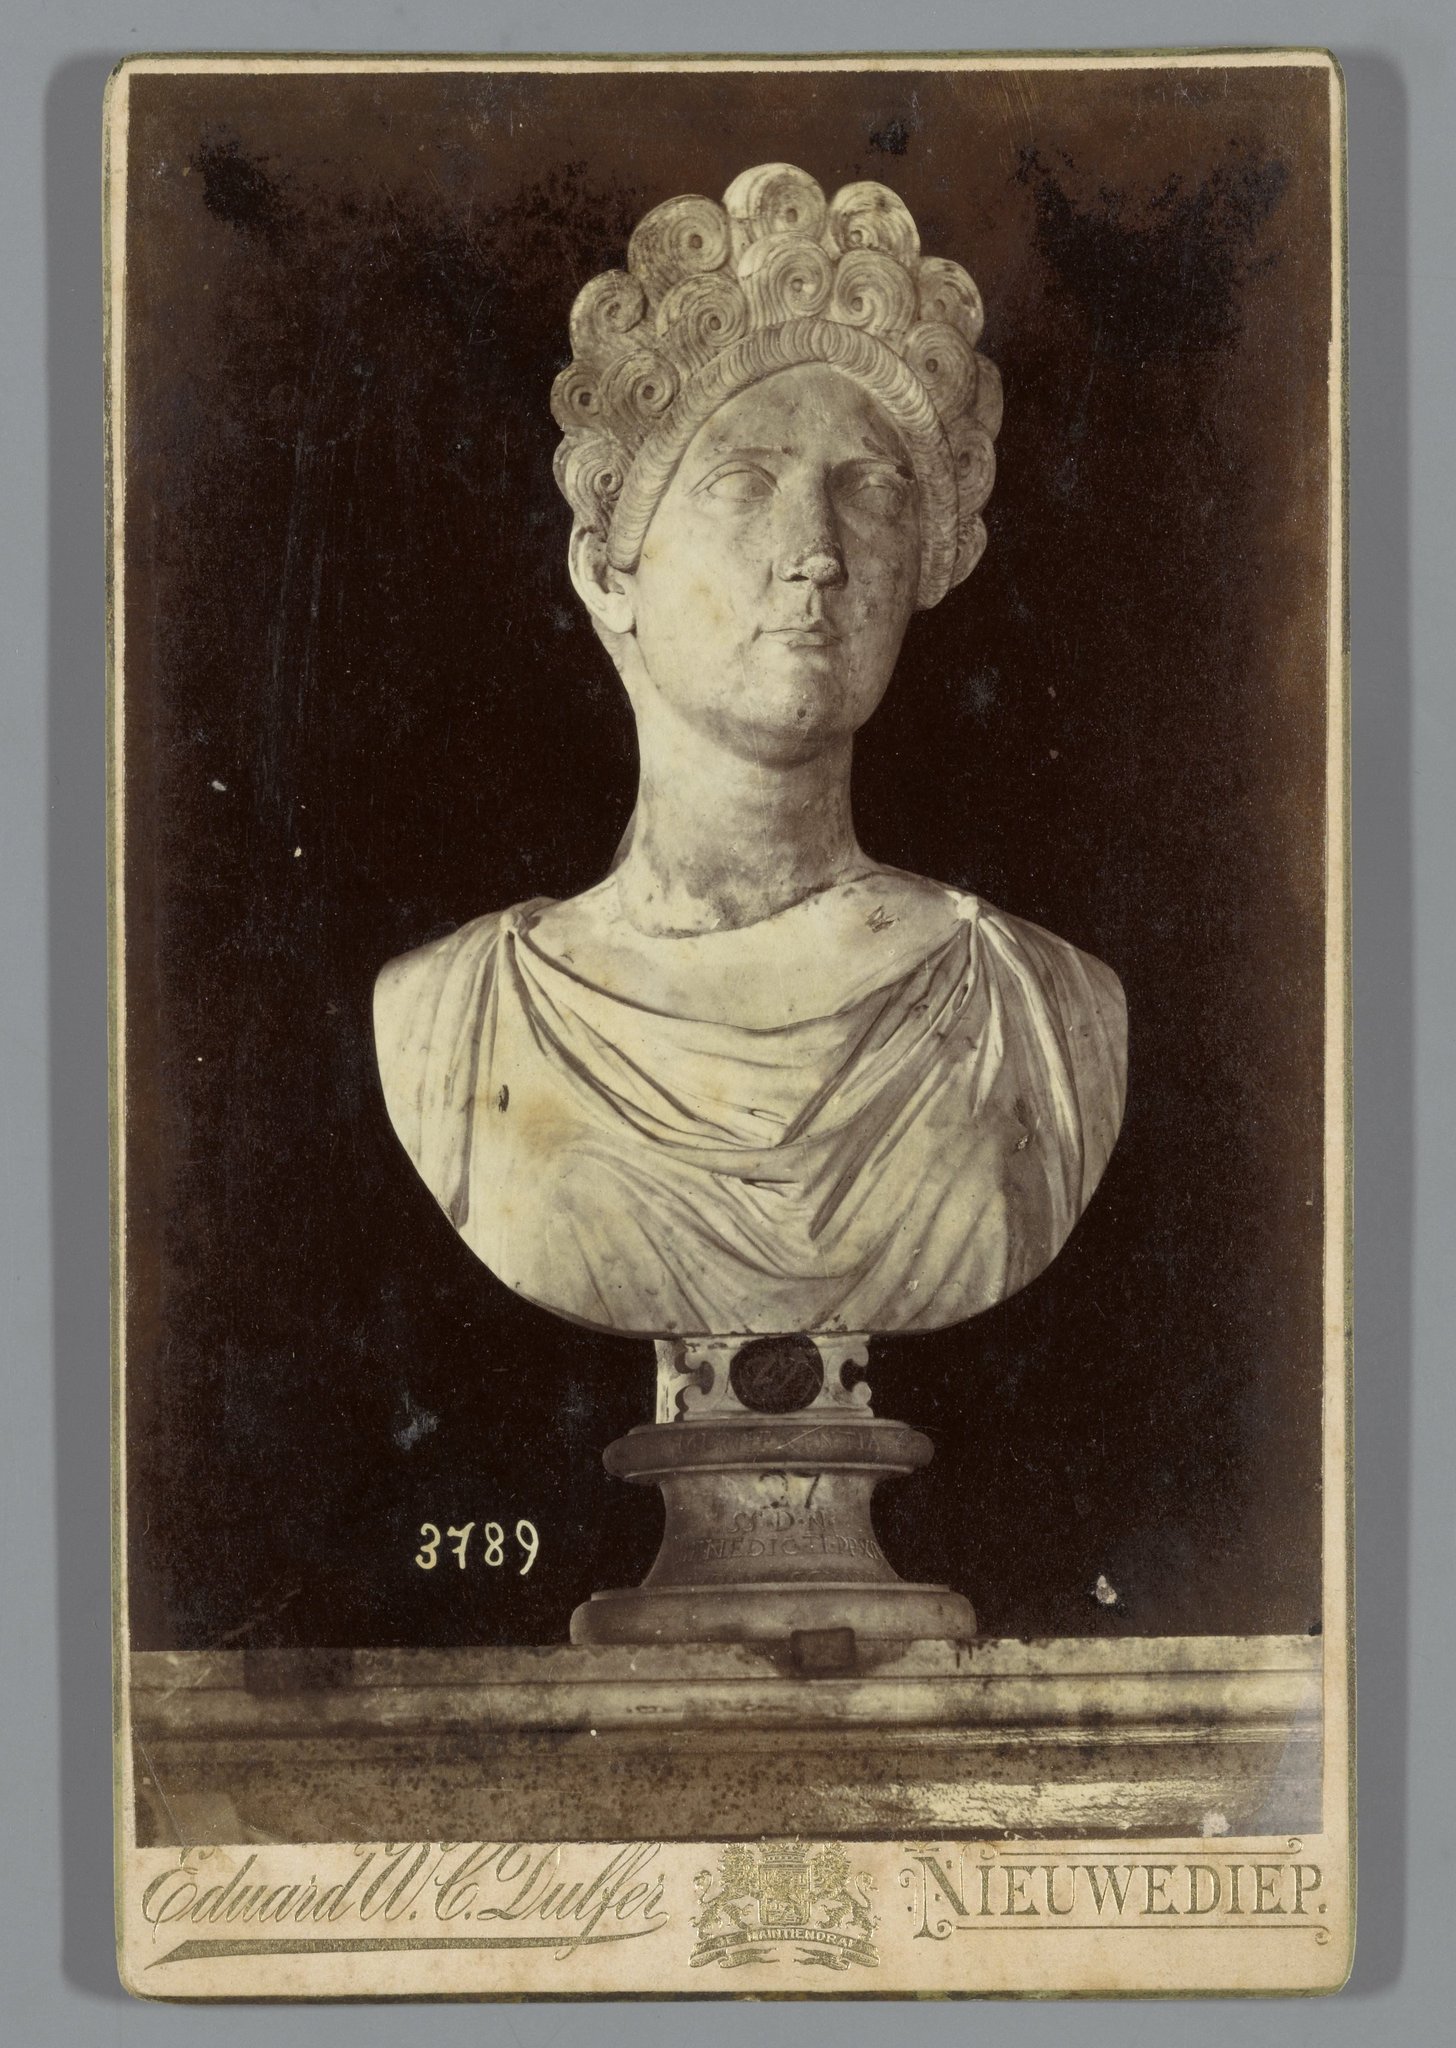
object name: cabinet photograph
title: Marciana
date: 1885-1895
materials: cardboard, paper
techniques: albumen print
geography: nieuwediep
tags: hair - aa - female human figure, piece of sculpture, reproduction of a piece of sculpture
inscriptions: number: ‘3789’, collector's mark: ‘Vosmaer’